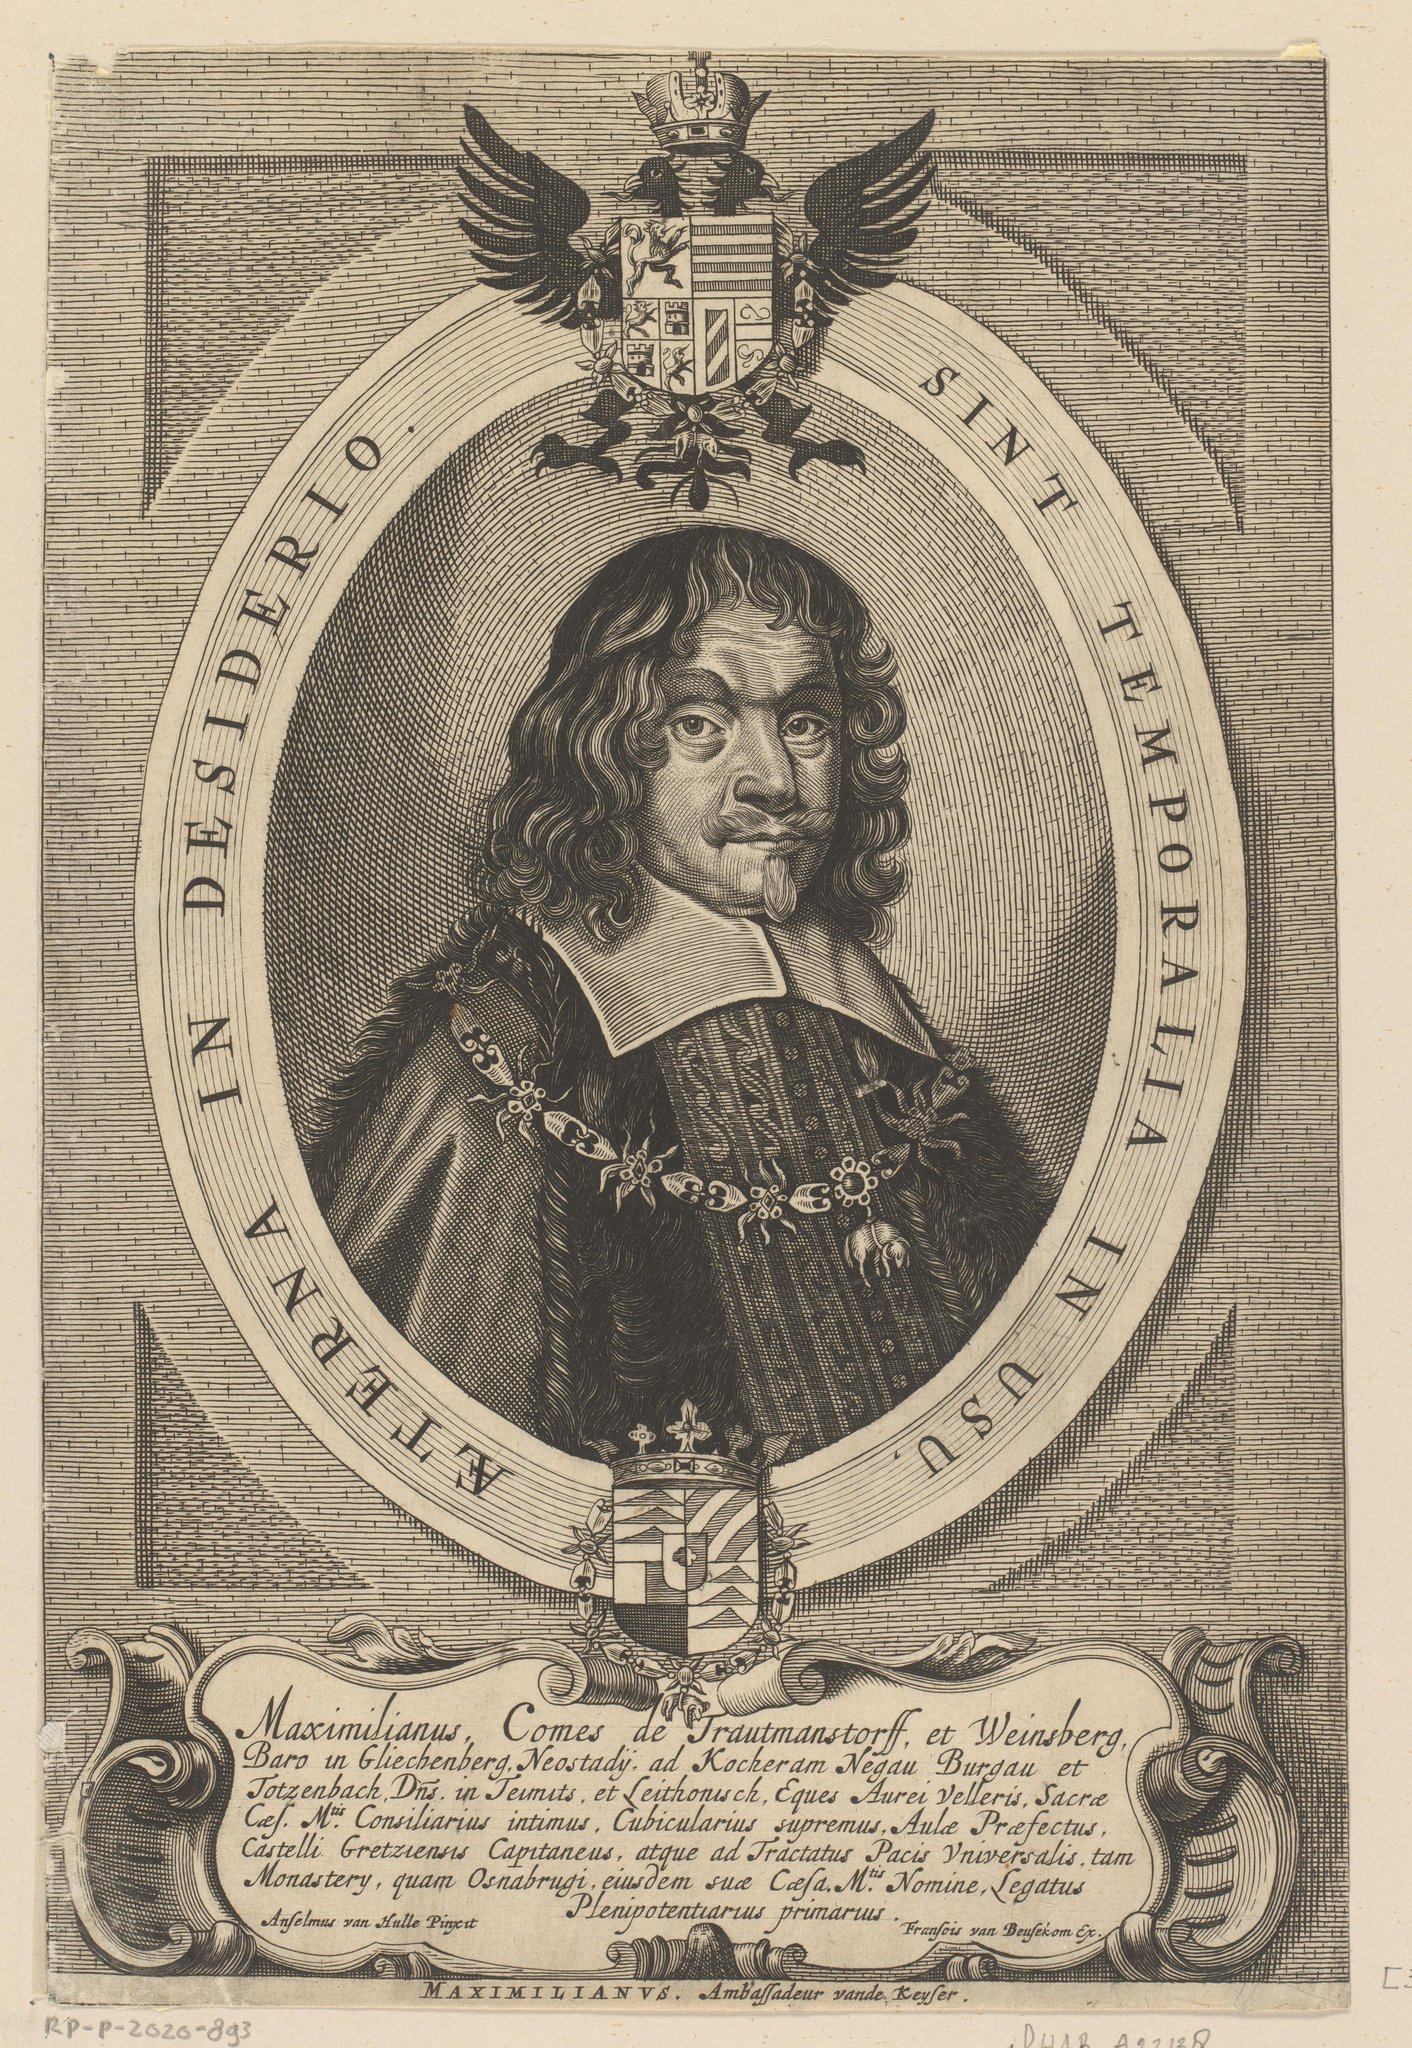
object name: print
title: Portret van Maximilian von Trauttmansdorff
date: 1648-1665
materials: paper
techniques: engraving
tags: official; civil servant; functionary (in general), historical persons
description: Spiegelbeeldige kopie naar een prent van Pieter de Jode II. Zie documentatie. De prent maakt waarschijnlijk onderdeel uit van een serie portretten met vredesonderhandelaars die betrokken waren bij de Vrede van Münster.